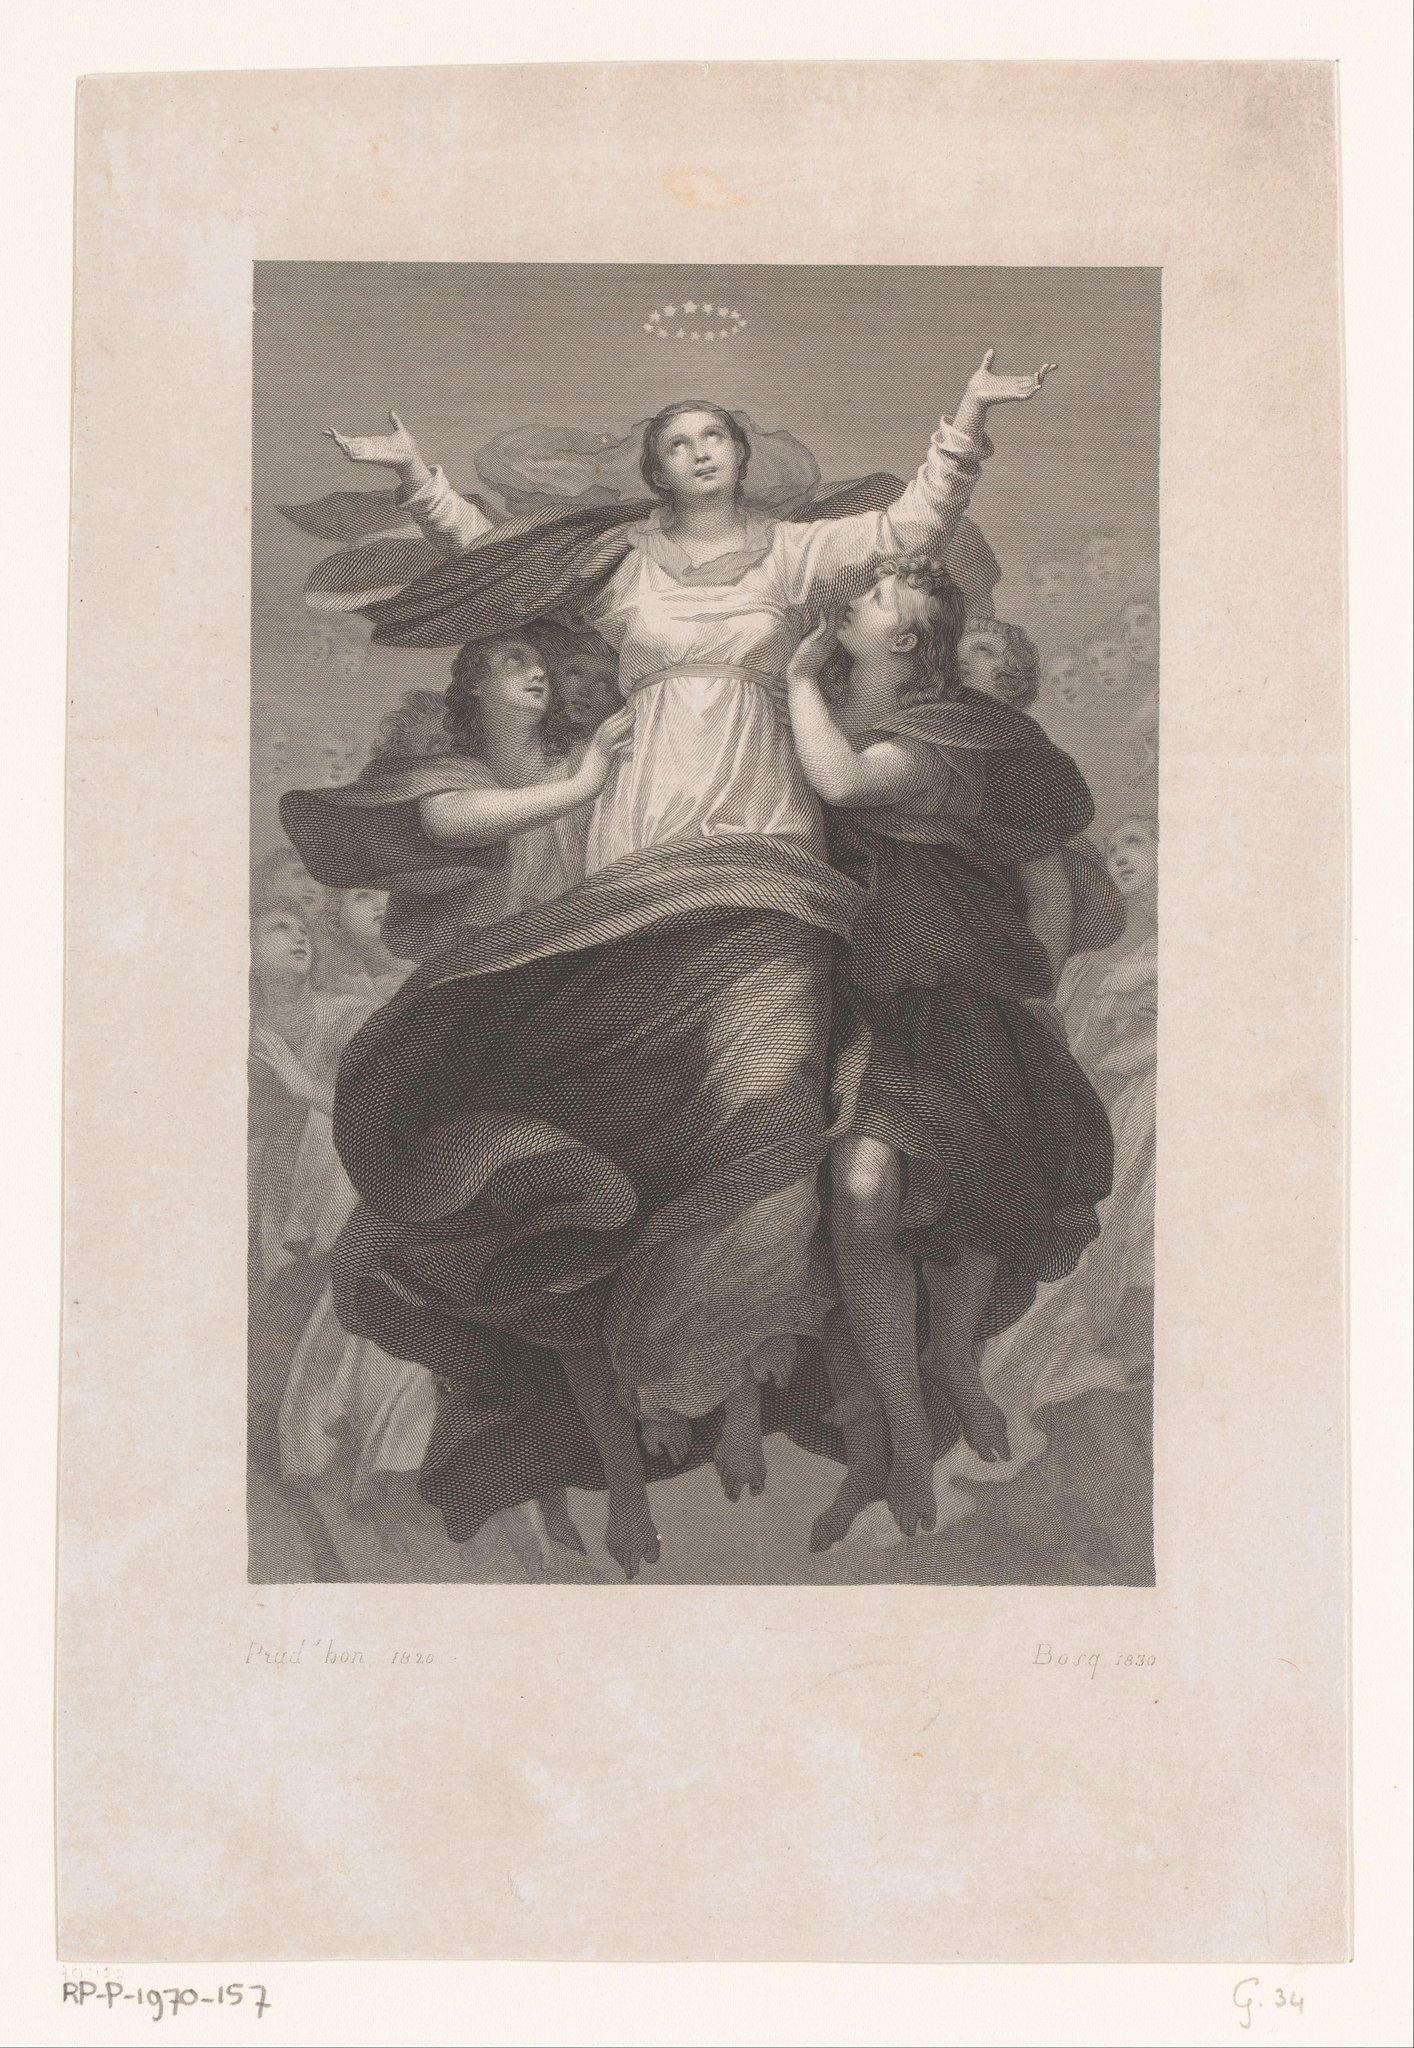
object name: print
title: Hemelvaart van Maria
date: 1830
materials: paper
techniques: engraving, etching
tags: the assumption of mary ('assumptio corporis'): she is borne into heaven by angels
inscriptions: collector's mark: Lugt 2760, collector's mark: Lugt 2228a